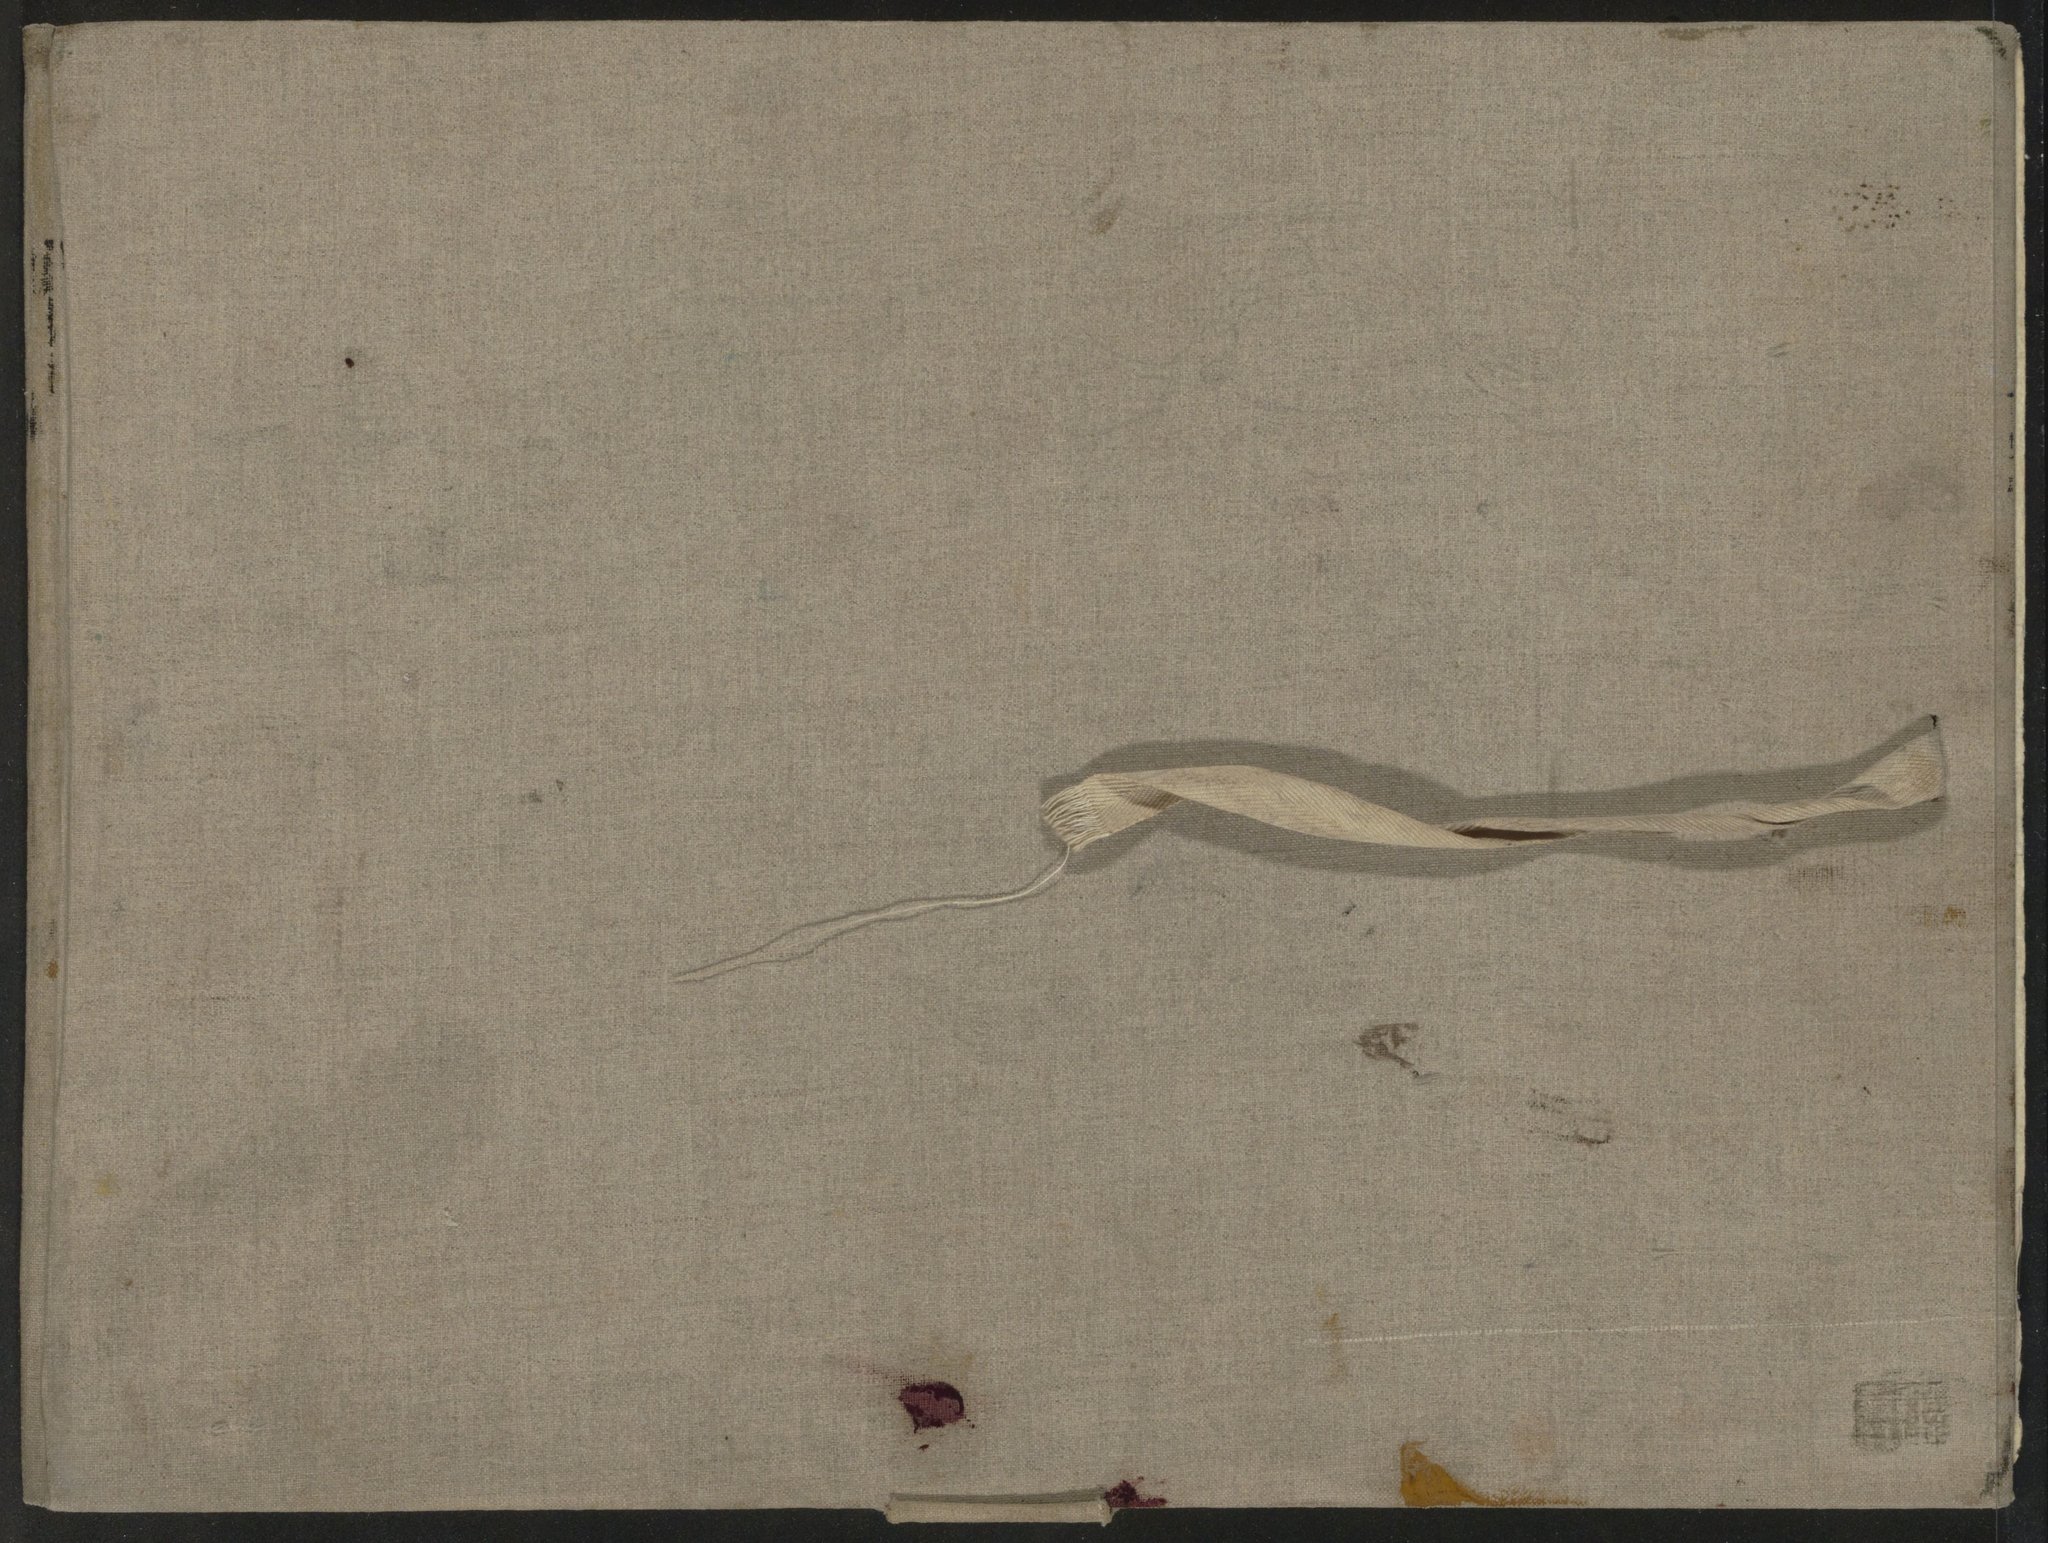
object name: sketchbook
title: Schetsboek met 7 bladen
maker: monogrammist ds (tekenaar)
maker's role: draughtsman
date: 1850-1950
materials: cardboard, chalk, linen, paper, pencil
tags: forest, wood, goat, beach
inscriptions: annotation: ‘f1.50/ W4-51/ 1’, collector's mark: Lugt 2228a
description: Schetsboek bestaande uit 7 bladen met bos- en strandgezichten, figuren en geiten.